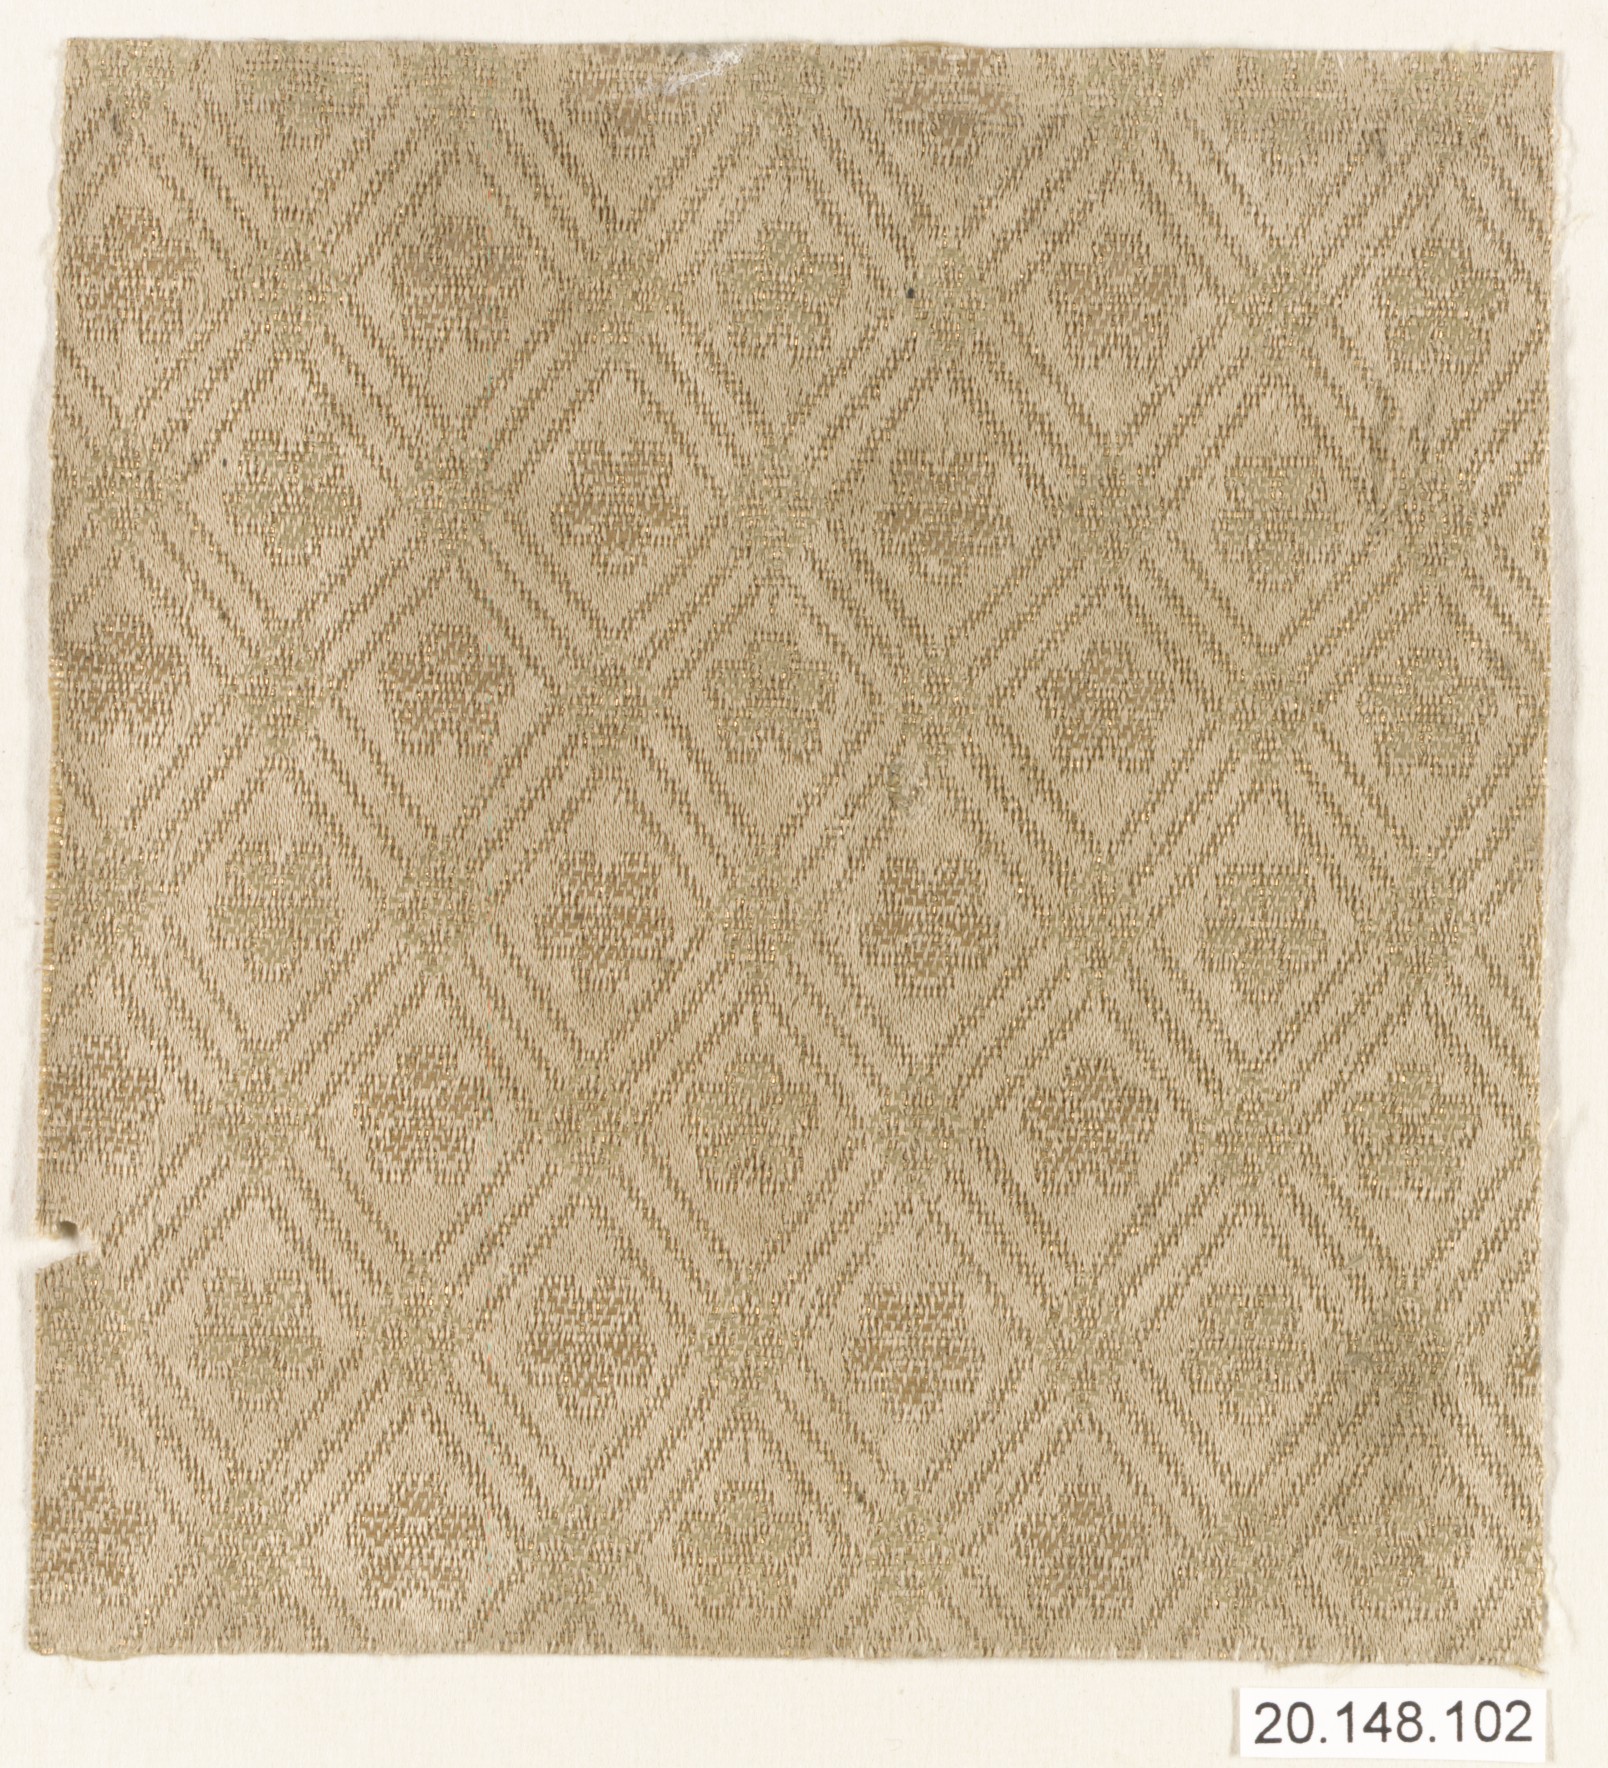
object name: piece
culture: japanese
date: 1701-1800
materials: silk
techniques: compound weave